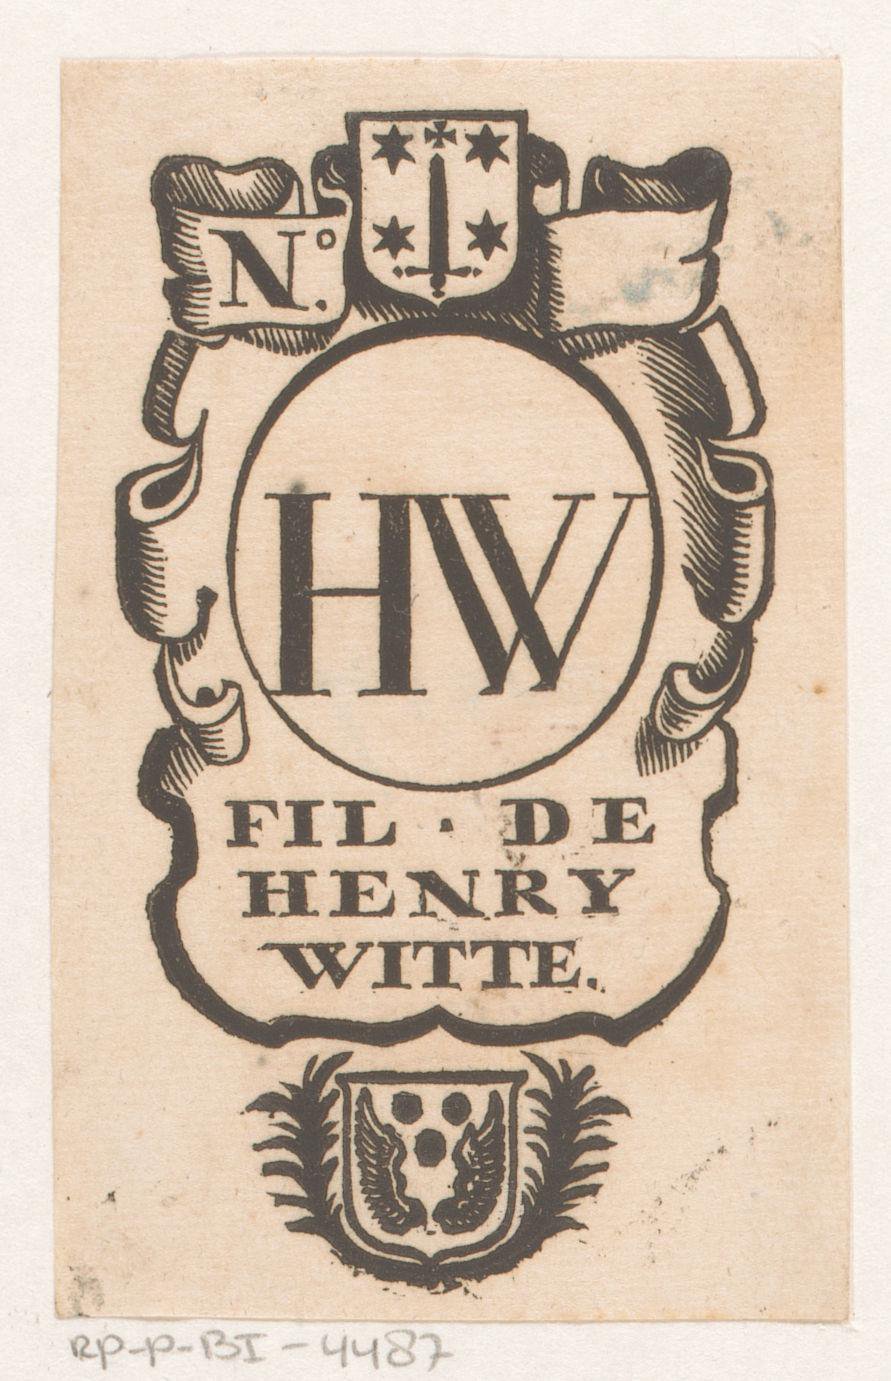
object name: print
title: Vignet met het monogram HW en het wapen van de stad Haarlem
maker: Anonymous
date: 1600-1699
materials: paper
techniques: woodcut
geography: netherlands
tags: coat of arms (as symbol of the state, etc.) (+ city; municipal), vignette, letter combinations such as letterword, anagram, letter square, monogram, etc., haarlem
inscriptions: collector's mark: Lugt 240